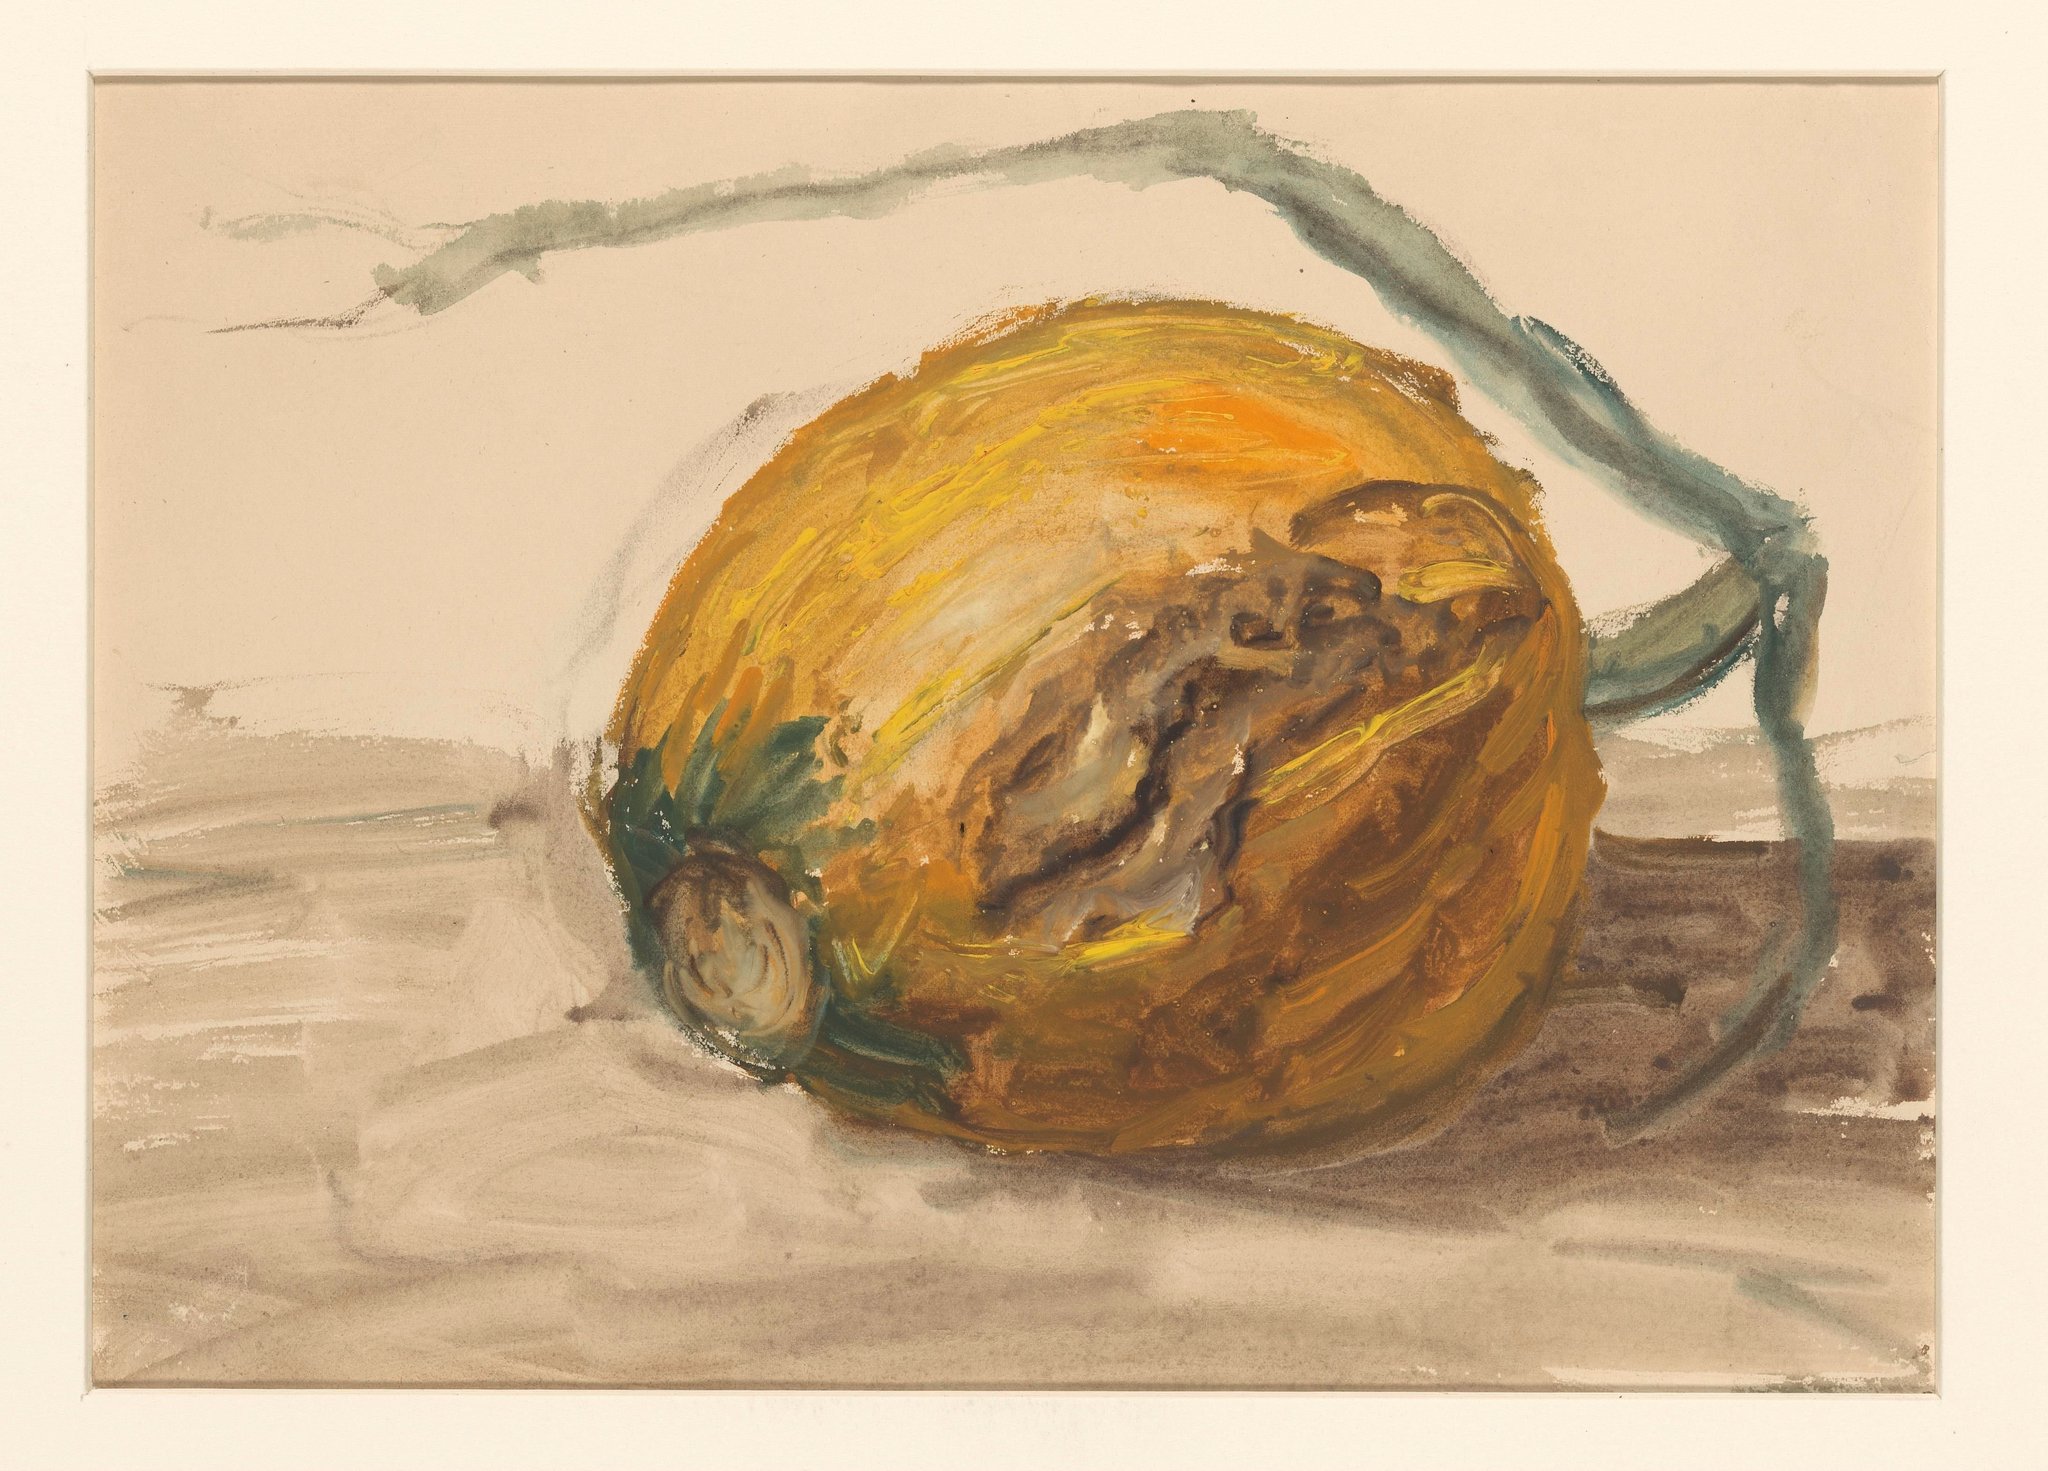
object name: drawing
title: Kalebas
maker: sientje mesdag-van houten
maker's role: draughtsman, painter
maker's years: 1834-1909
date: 1844-1909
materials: paper, watercolor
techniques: brush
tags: fruits: gourd